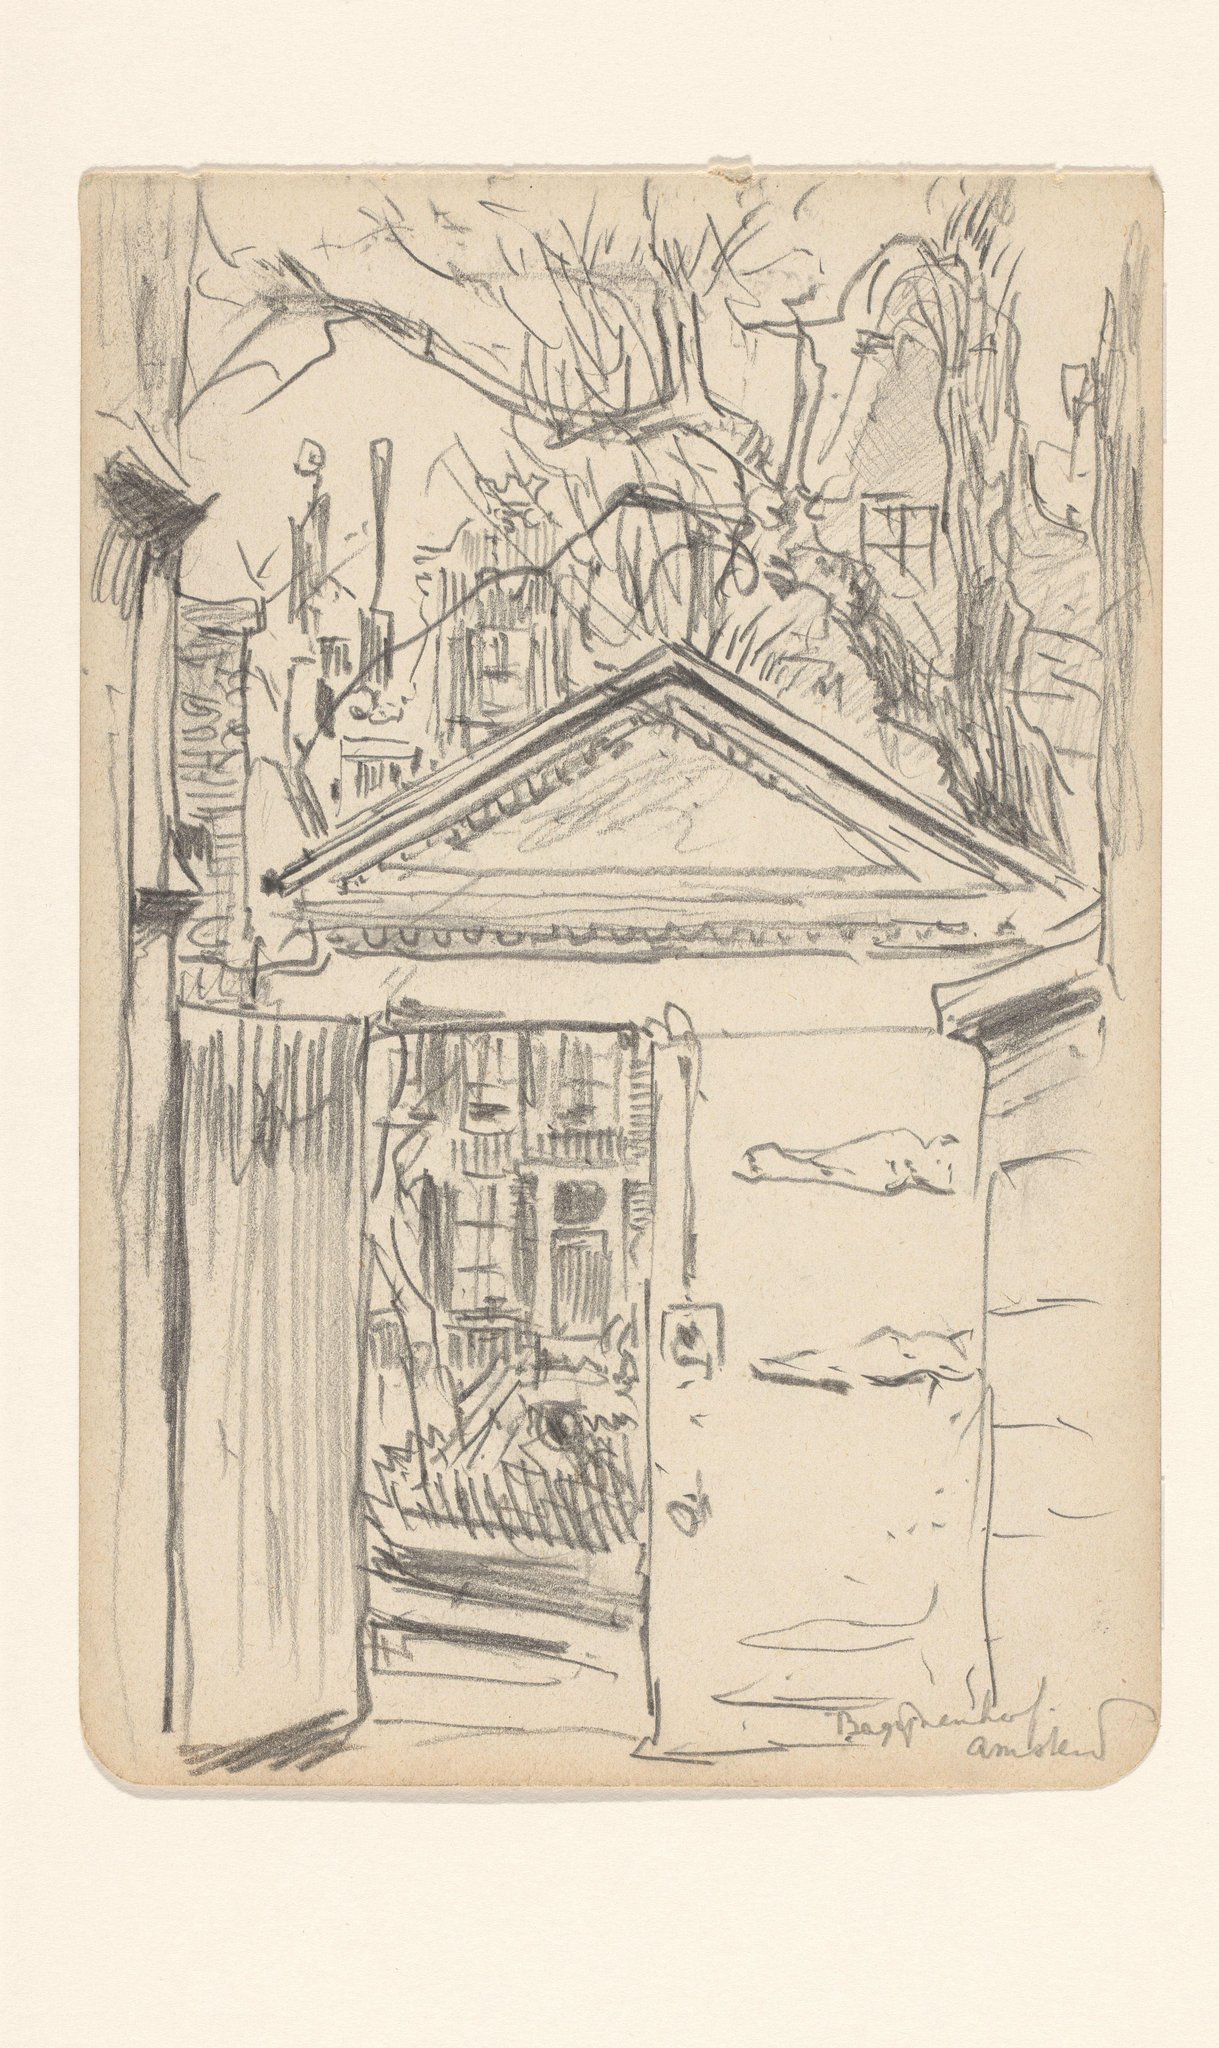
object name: drawing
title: Poort naar het Begijnhof te Amsterdam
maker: jan hoynck van papendrecht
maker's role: draughtsman, painter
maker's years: 1858-1933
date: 1868-1933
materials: paper, pencil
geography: amsterdam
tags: gate, entrance, courtyard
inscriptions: annotation: ‘Bagijnenhof./ Amsterd’